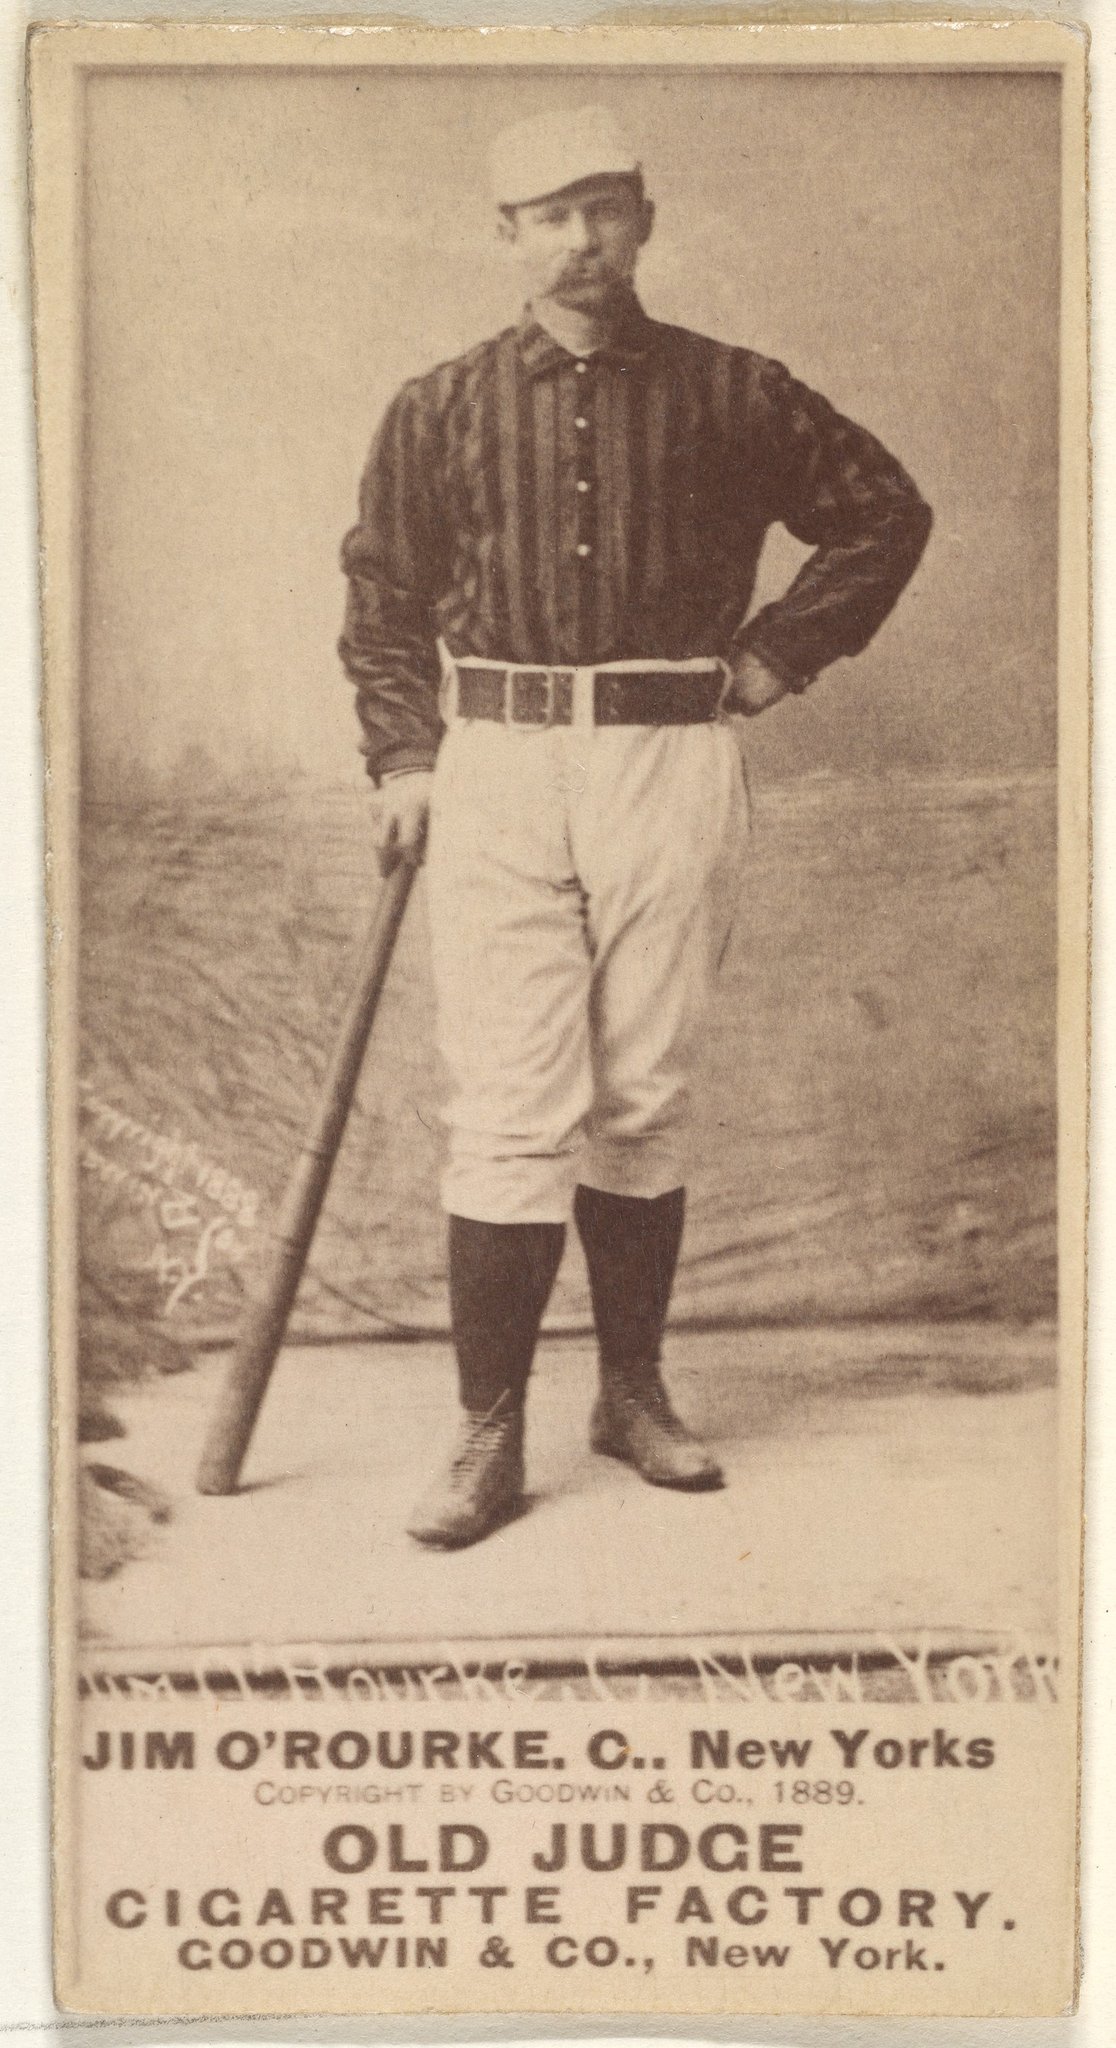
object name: baseball card, photograph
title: James Henry O'Rourke, 3rd Base, New York, from the Old Judge series (N172) for Old Judge Cigarettes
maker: goodwin & company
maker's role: publisher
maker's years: 1850-1950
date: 1889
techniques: albumen silver print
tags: men,portraits,baseball,athletes